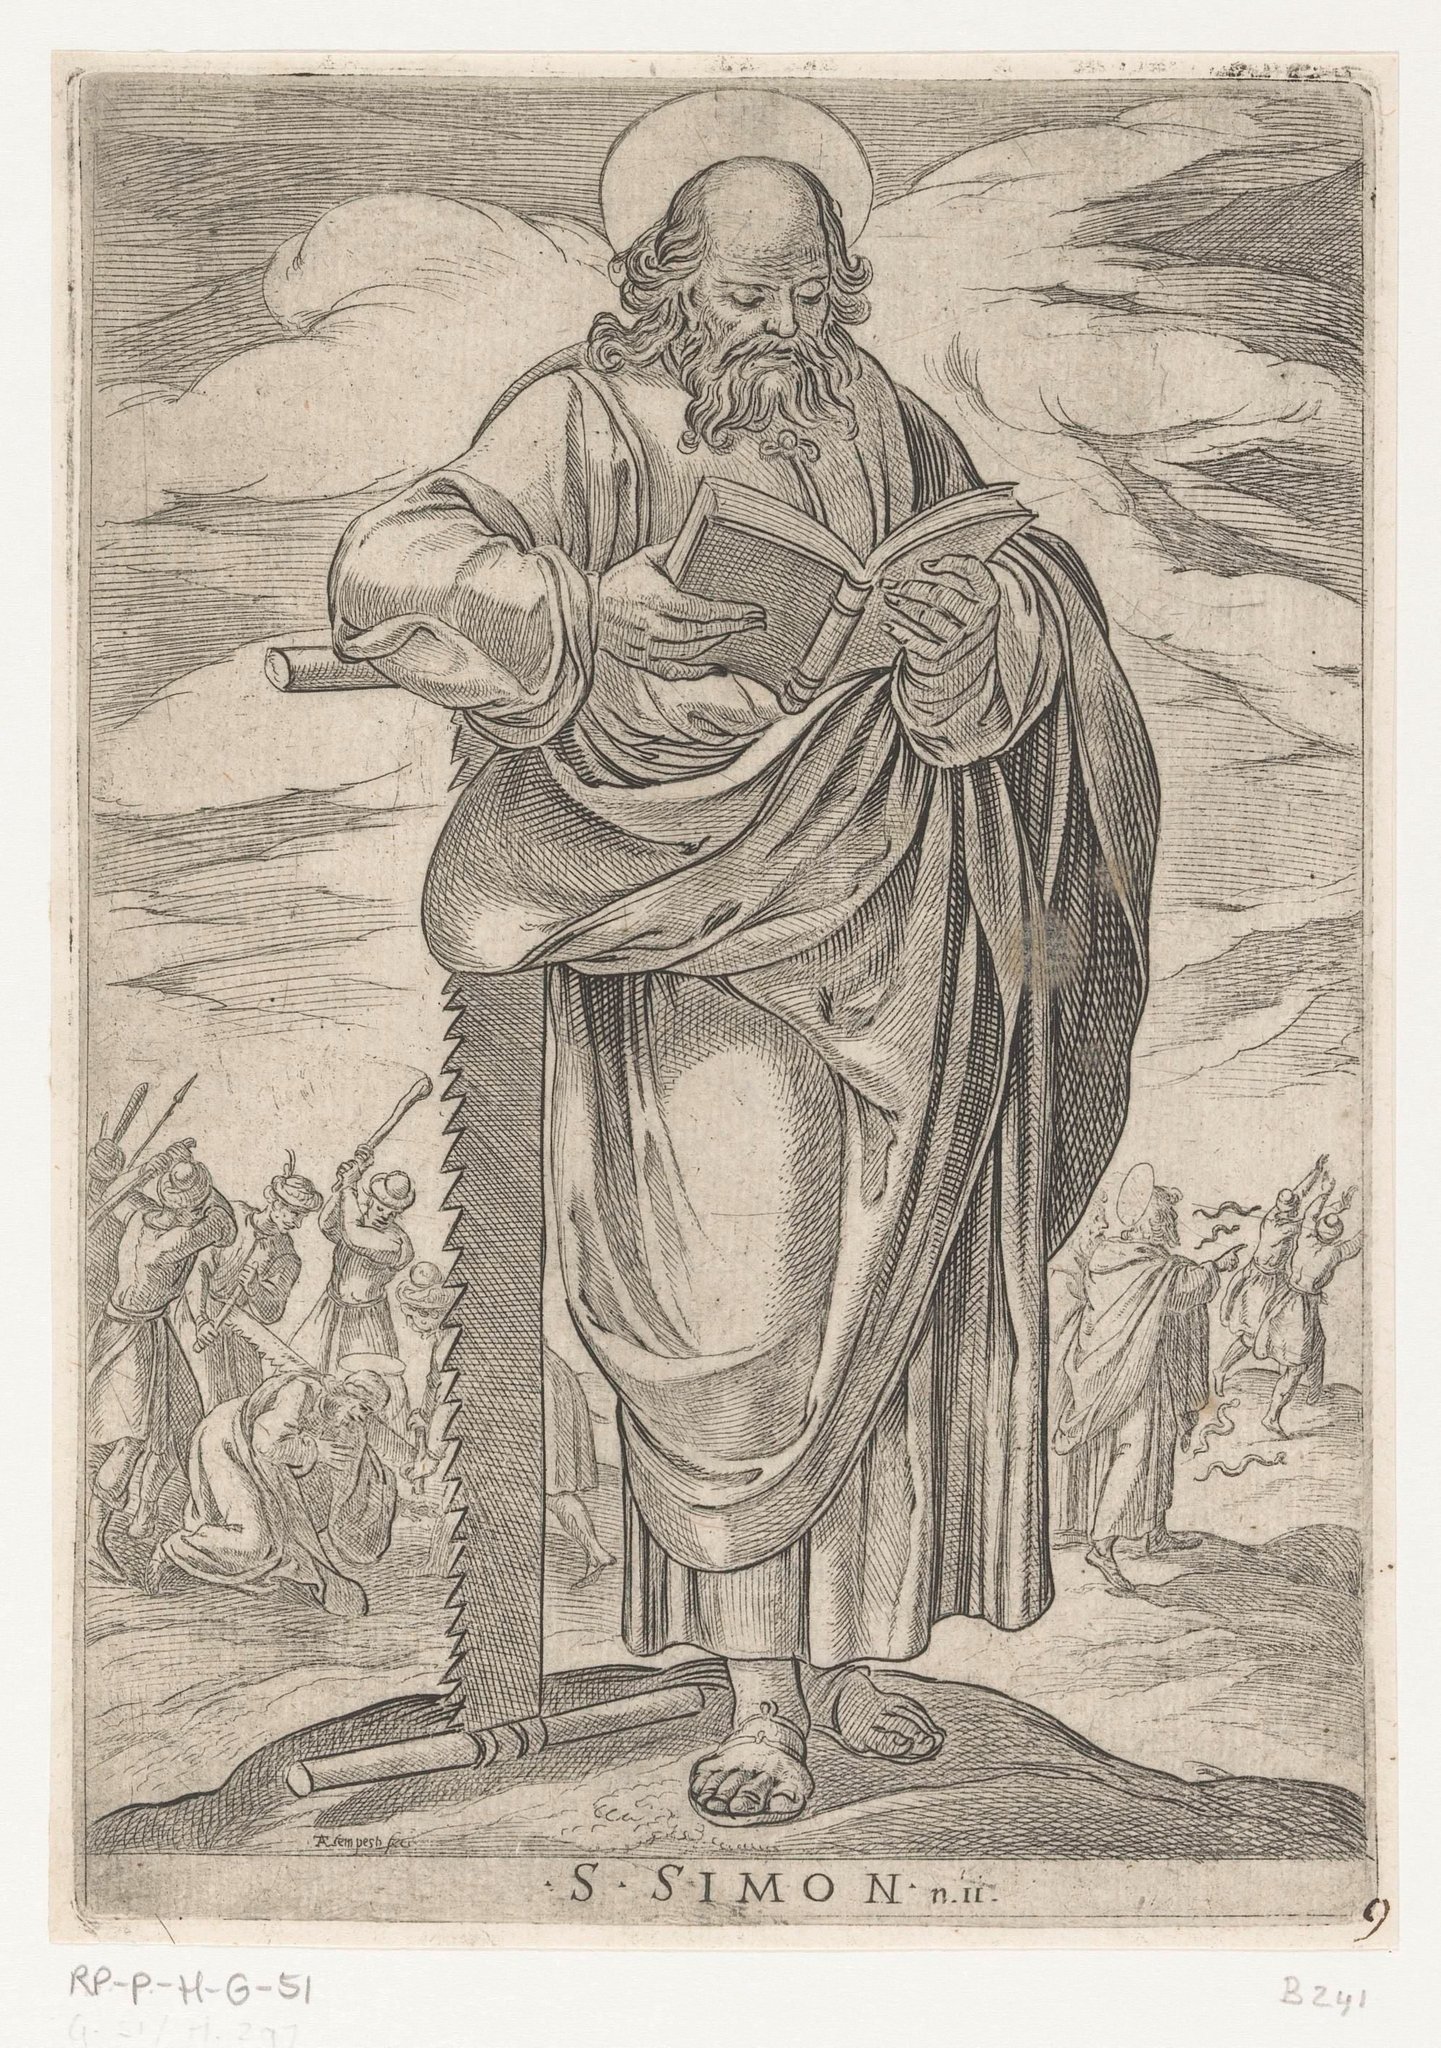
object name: print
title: De heilige Simon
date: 1565-1630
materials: paper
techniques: etching, intaglio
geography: italy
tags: life and acts of simon zelotes, the apostle simon zelotes (or simon the canaanite); possible attributes: book, saw, scroll, martyrdom and death of simon zelotes: he is sawn in two, or beaten to death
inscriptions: collector's mark: Lugt 11, number: ‘9’, collector's mark: ‘Hinloopen’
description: Deze prent maakt deel uit van een reeks van 15 prenten. De prenten met Maria en Christus zijn ongenummerd. De prenten met de apostelen zijn genummerd van 1 tot en met 13.